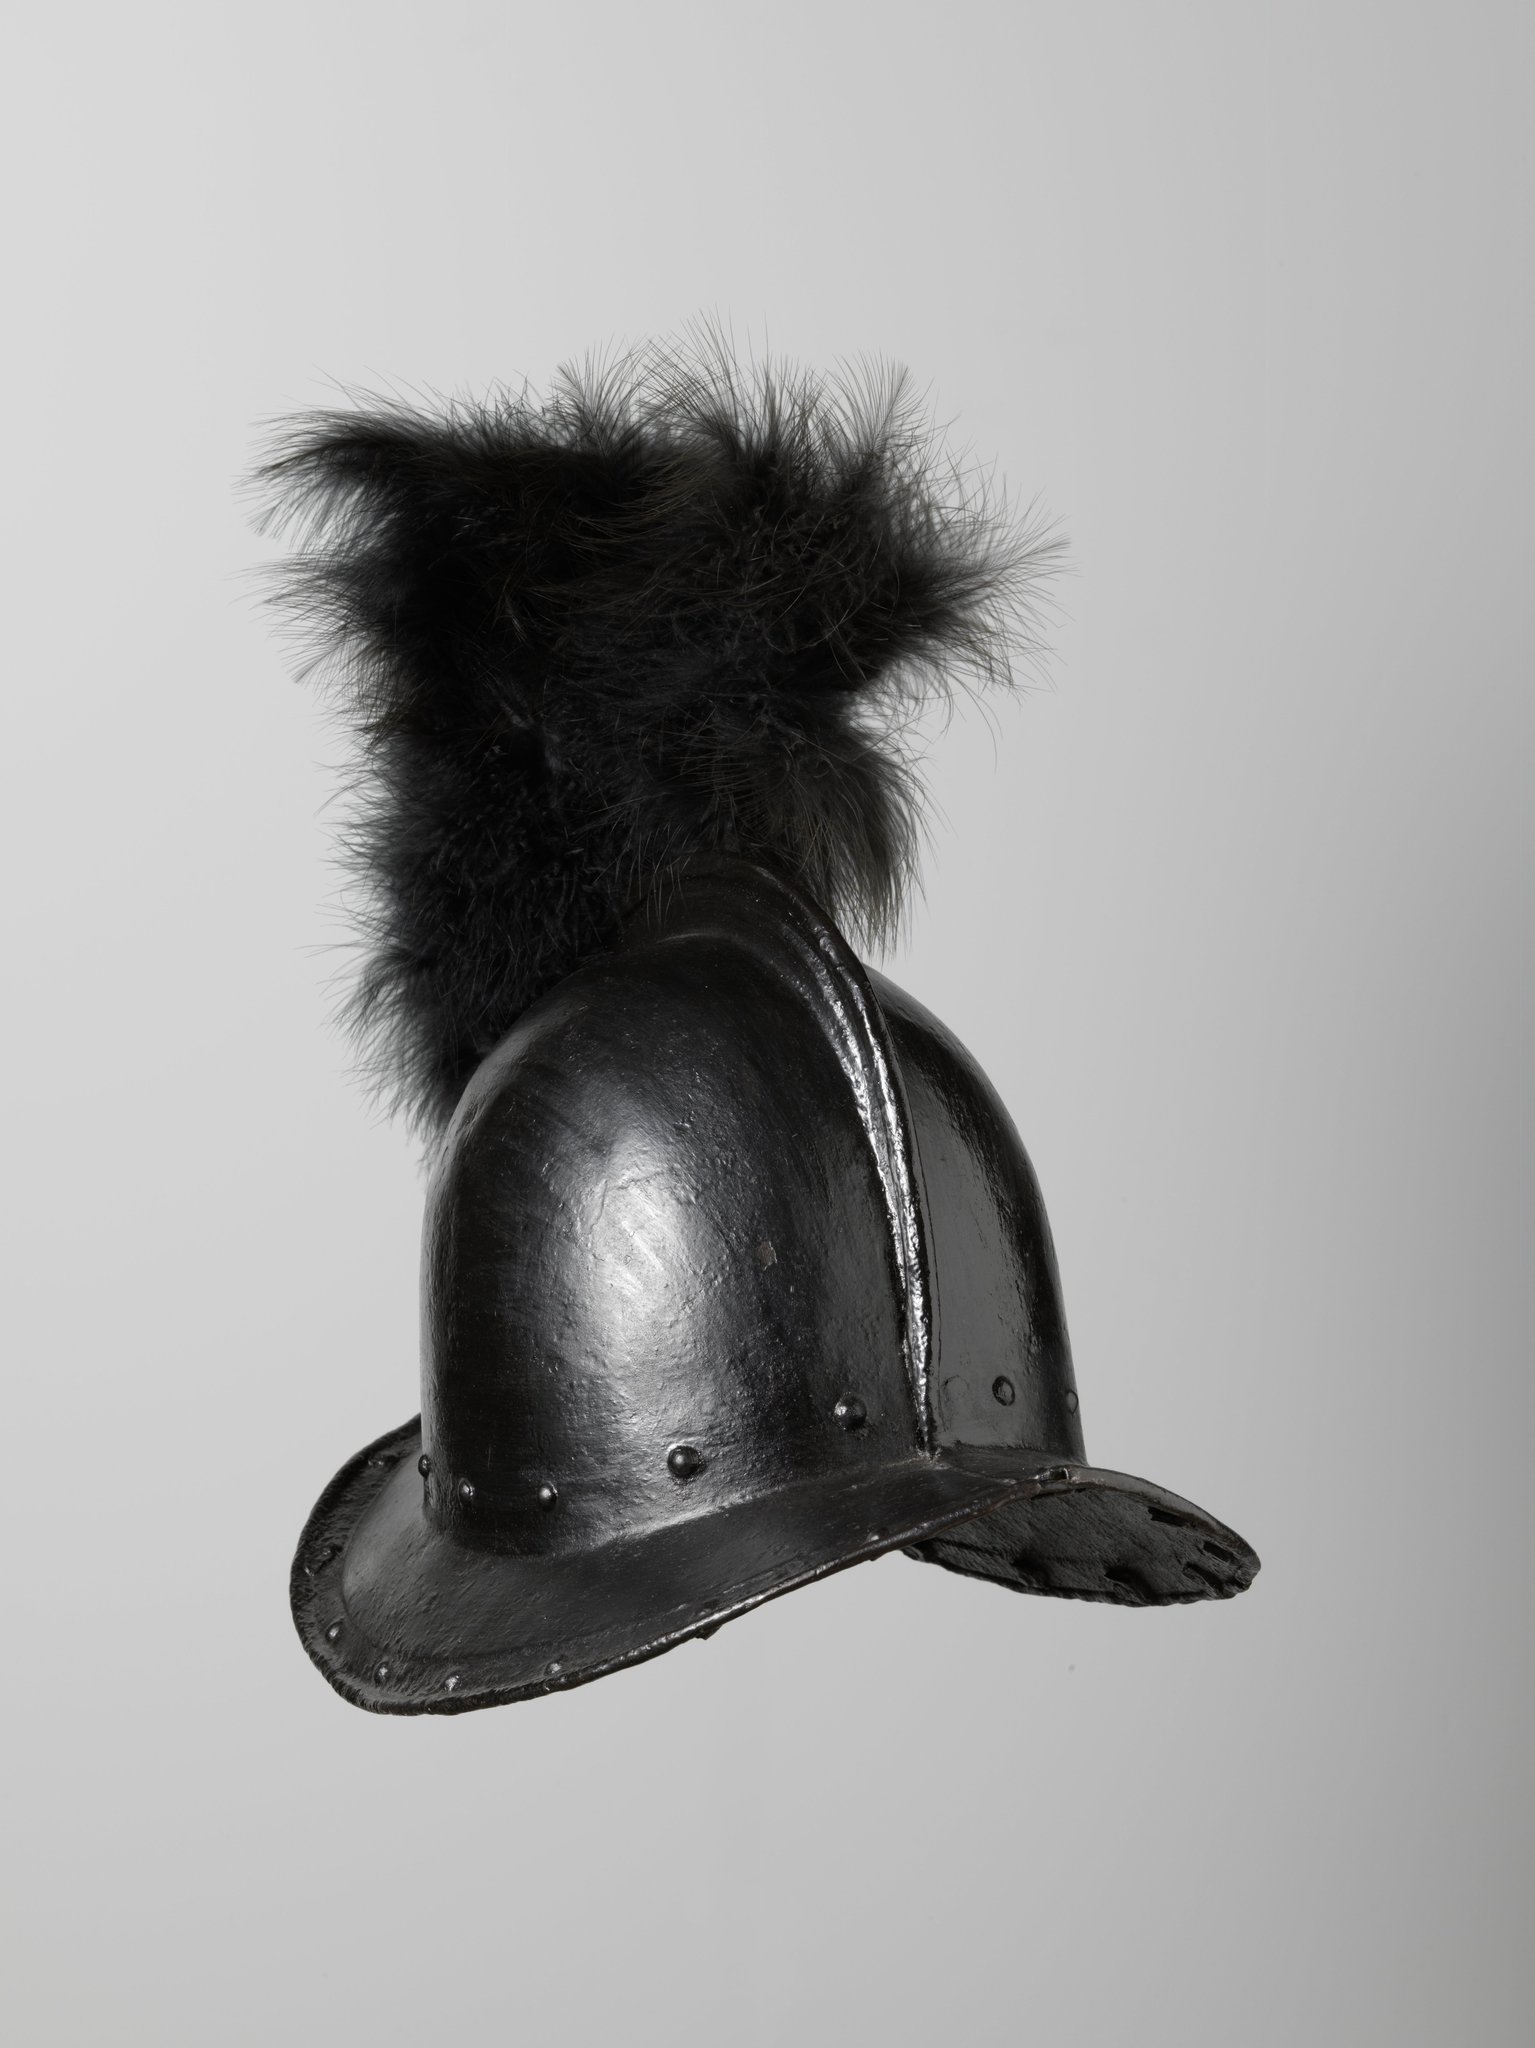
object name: helmet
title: Hollandse piekenierspot, zwart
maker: Anonymous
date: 1600-1699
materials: iron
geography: netherlands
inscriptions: number: ‘532’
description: Hollandse piekenierspot, ijzer, gezwart, samengesteld uit twee helften met klep die van voren en achteren iets omhoog gebogen is. Op de hoge helmbol een kam die aan de achterzijde eindigt in de pluimkoker. Rondom de basis van de helmbol veertien klinknagels. Rondom de klep achttien klinknagels. In de pluimkoker is een zwarte pluim bevestigd. Aan de voorzijde zit een rond gat. Binnenkant van de helm zit in de helmbol de gleuf van de middengraat.